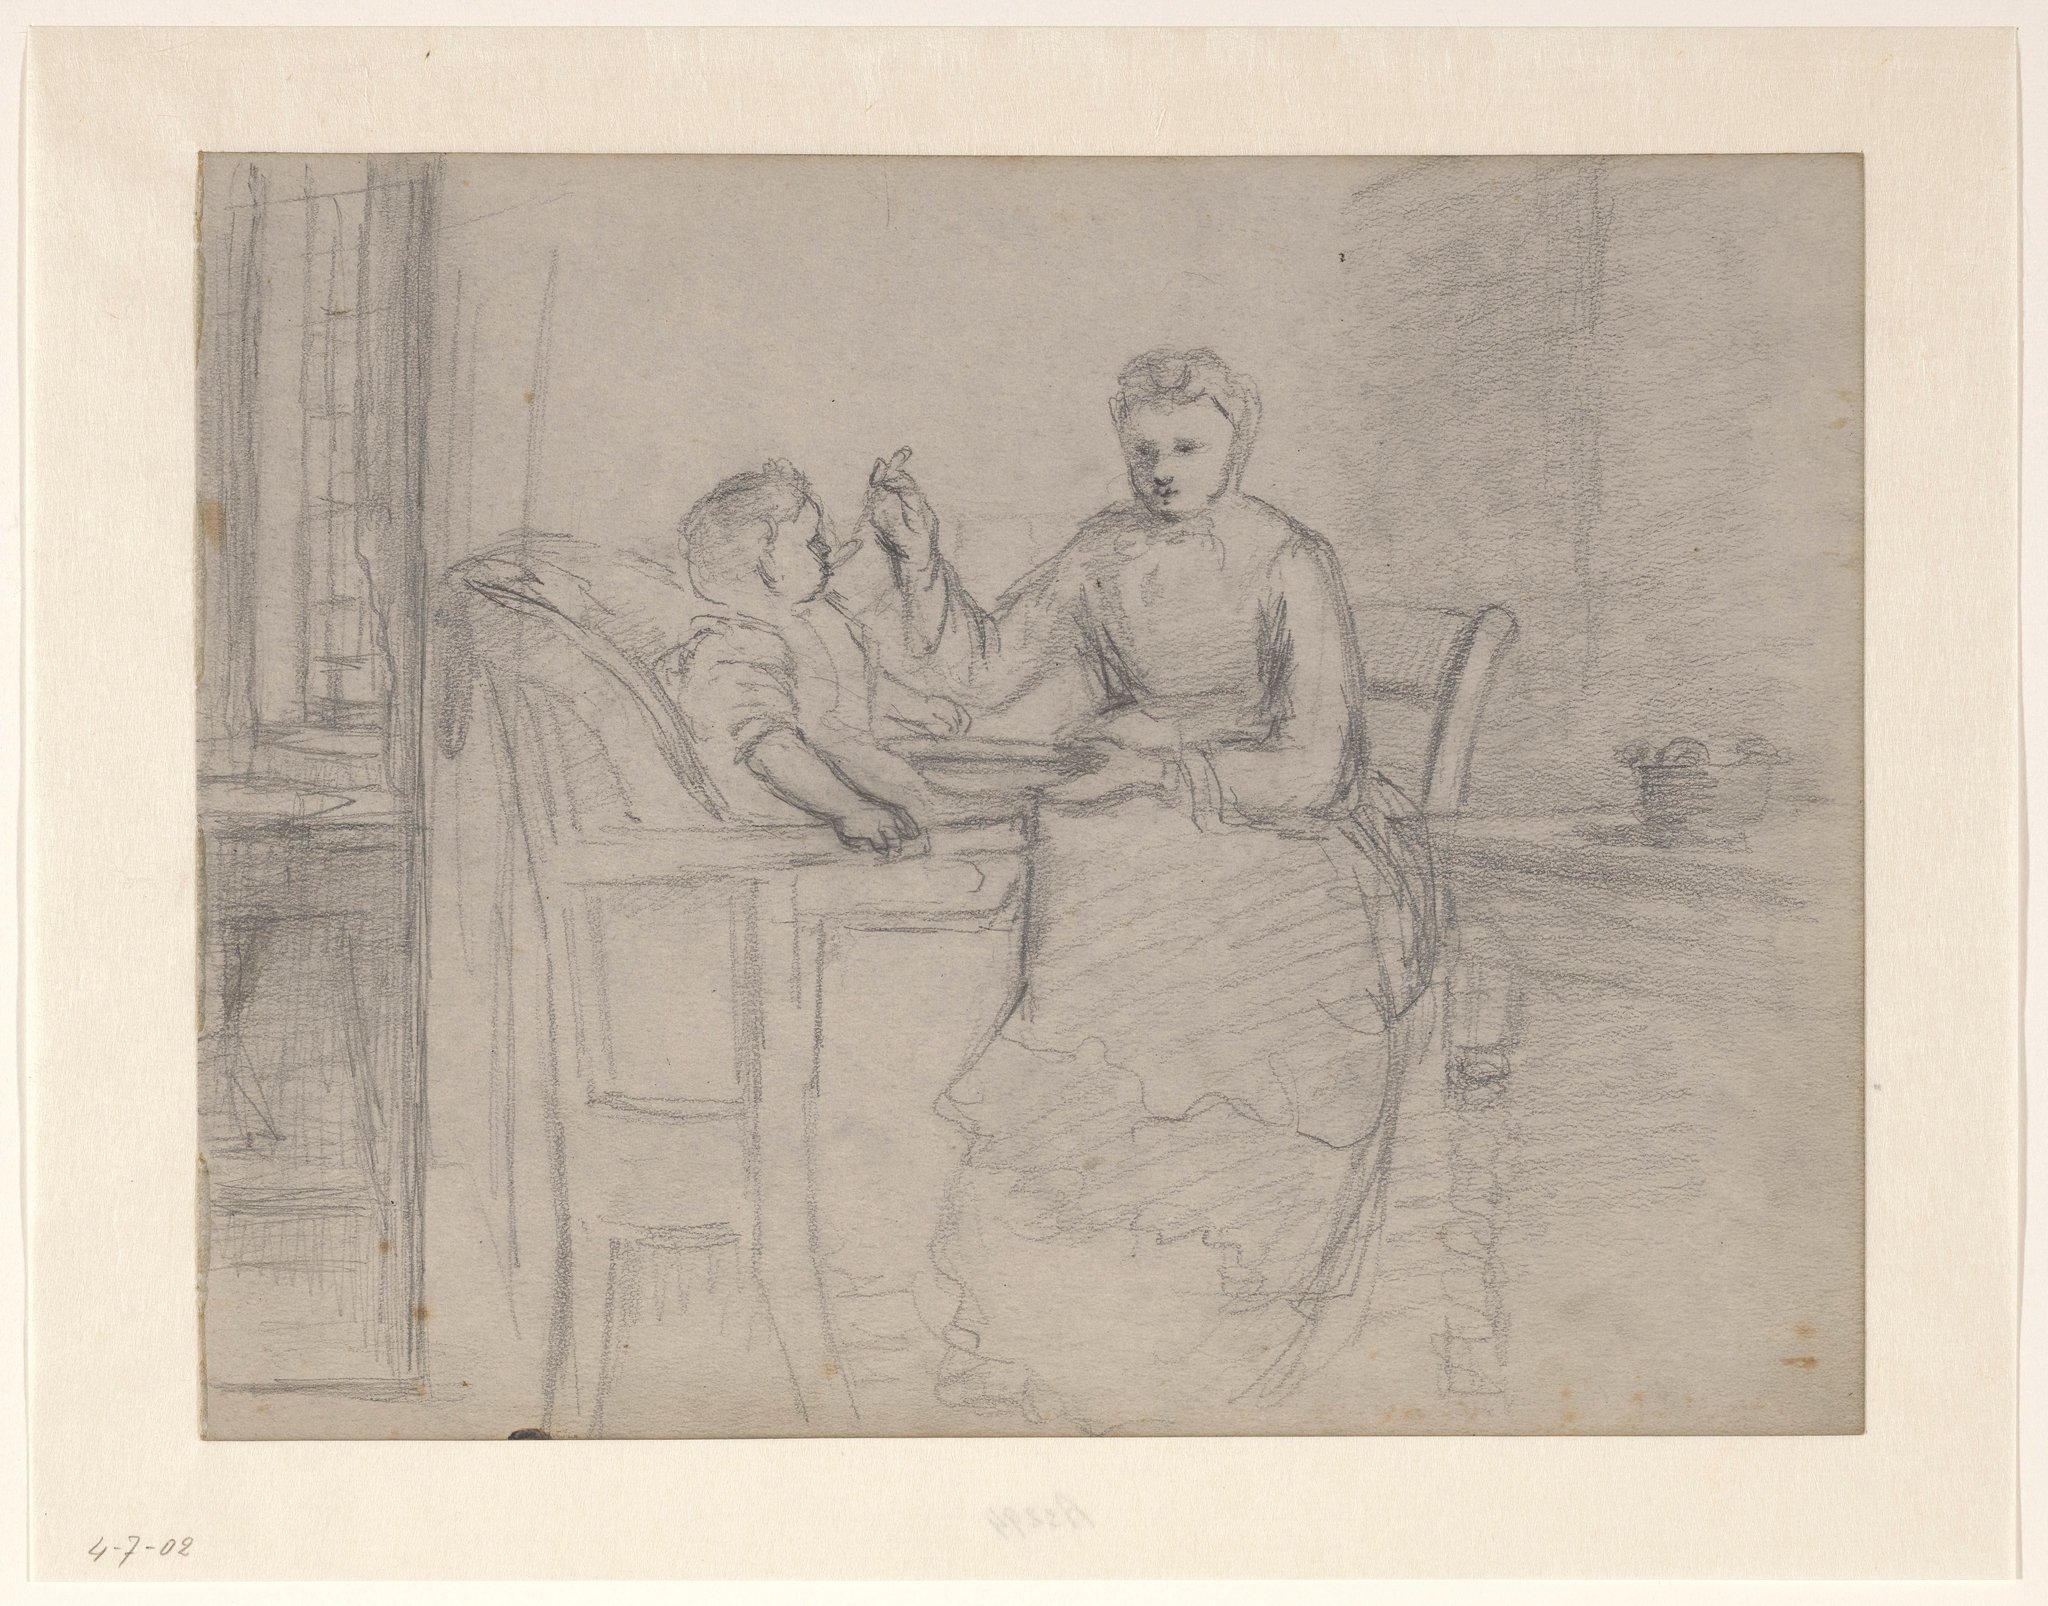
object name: drawing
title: Moeder met een kind in een kinderstoel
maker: hendrik valkenburg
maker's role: draughtsman, painter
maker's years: 1826-1896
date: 1836-1896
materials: paper, pencil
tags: mother and child(ren), woman and child(ren) (family group)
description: Zittende jonge moeder, van voren, met een kind in een kinderstoel. Verso: schetsen van moeders met kinderen.